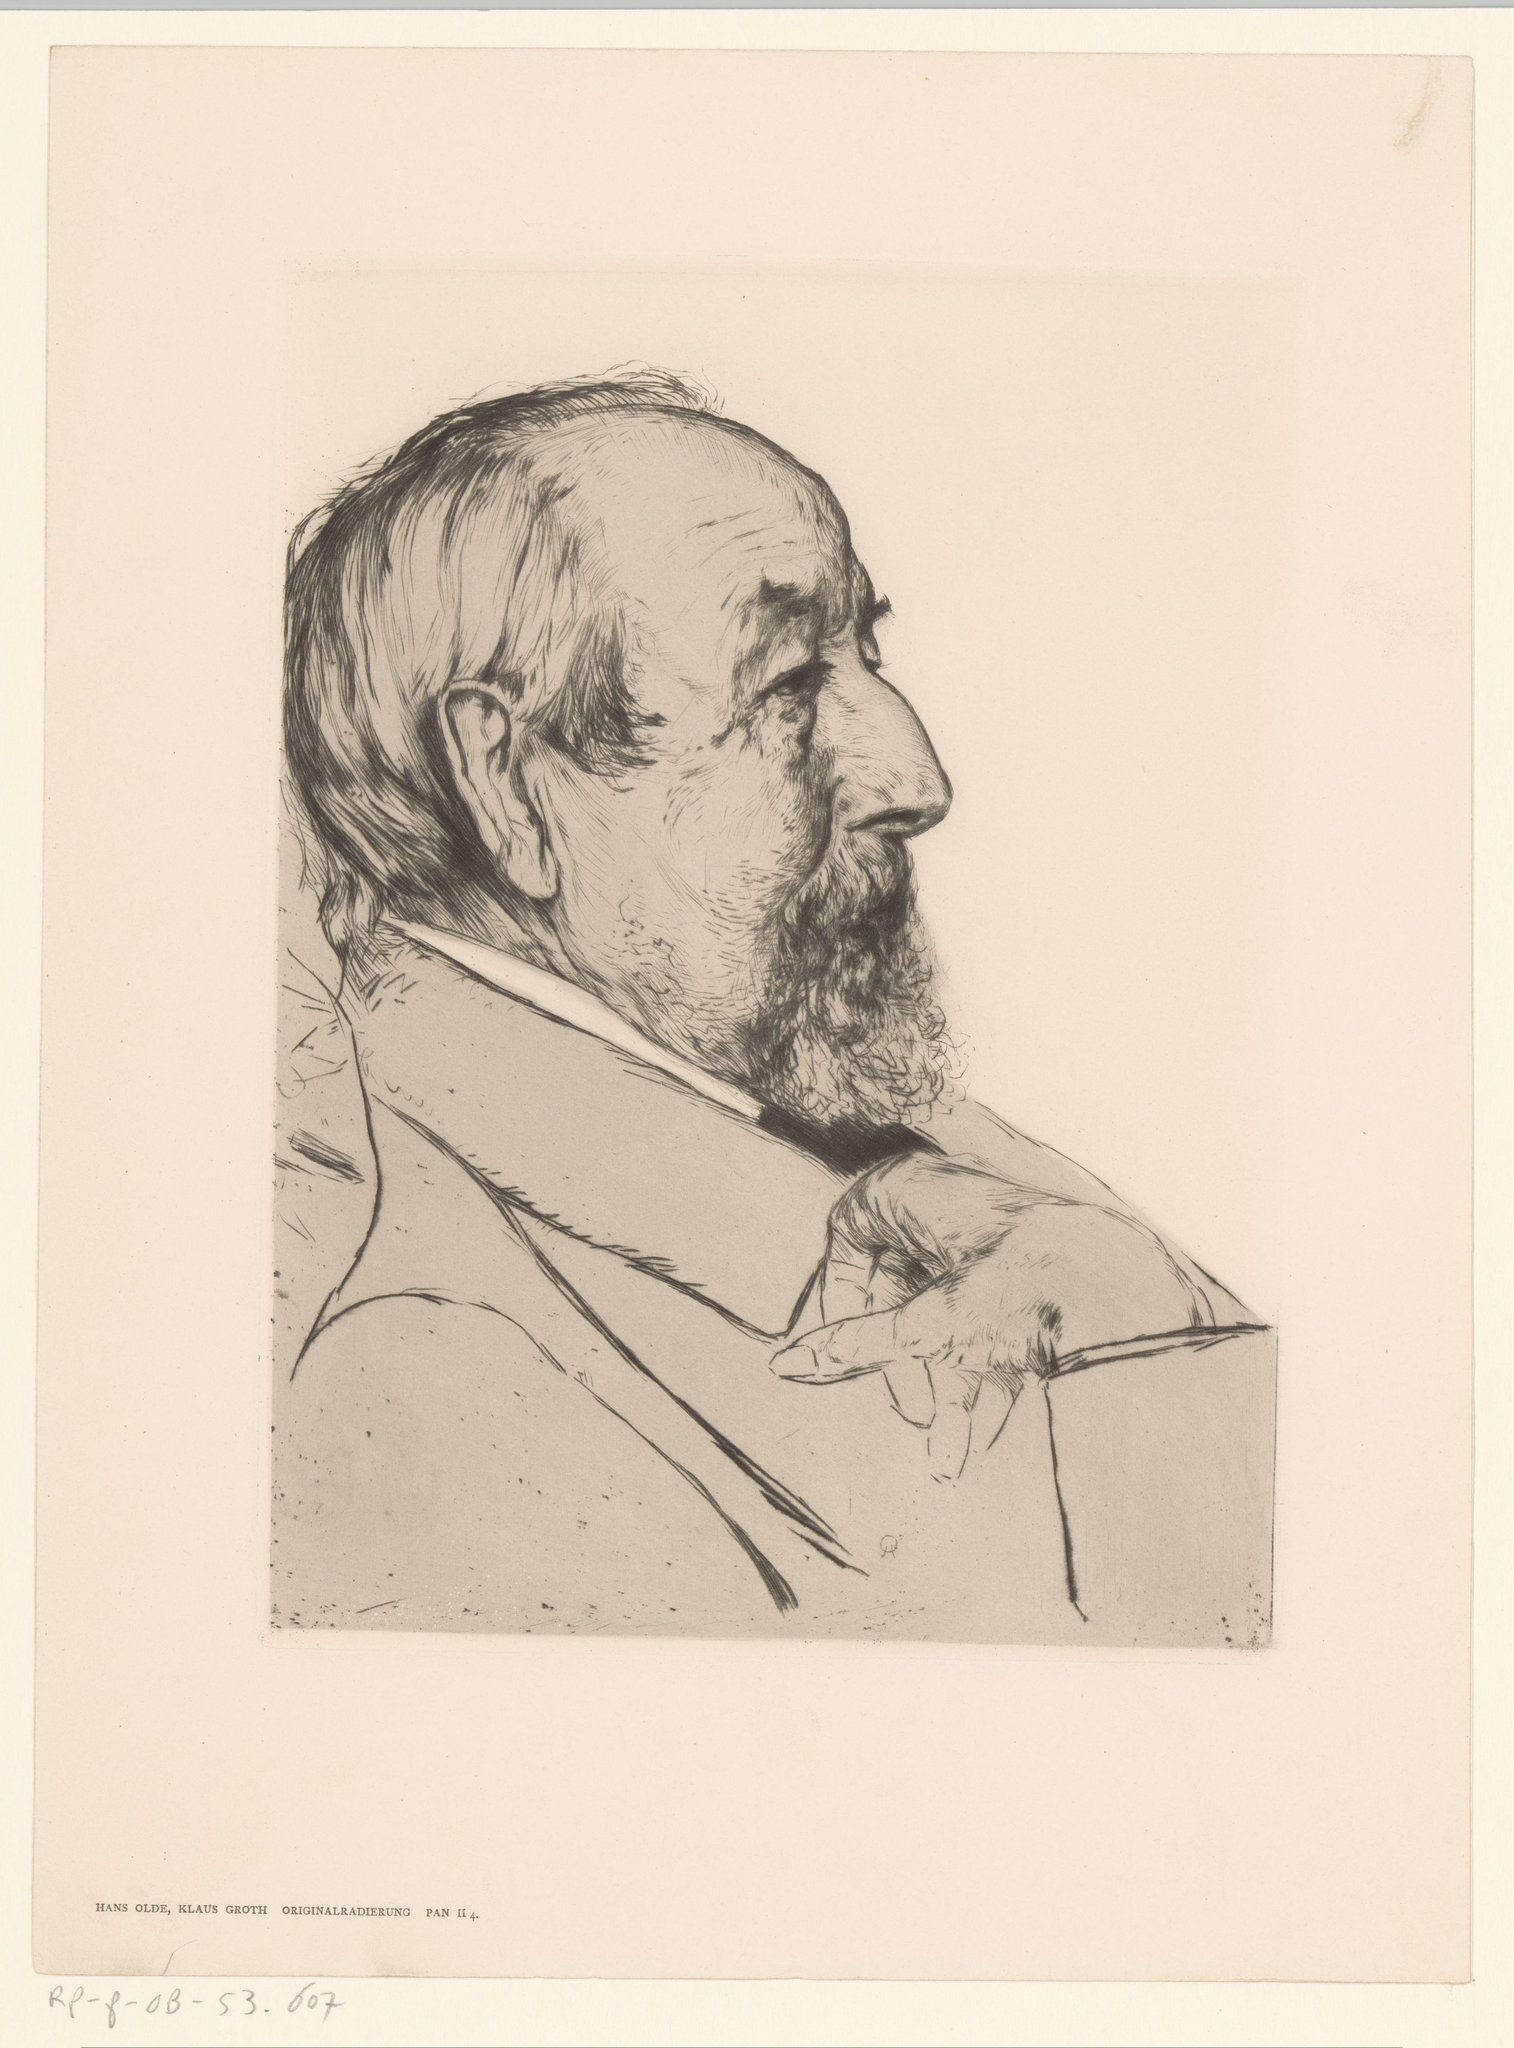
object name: print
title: Portret van Klaus Groth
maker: hans olde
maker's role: print maker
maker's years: 1855-1917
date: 1870-1917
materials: paper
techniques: drypoint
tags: historical persons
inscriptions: collector's mark: Lugt 2228